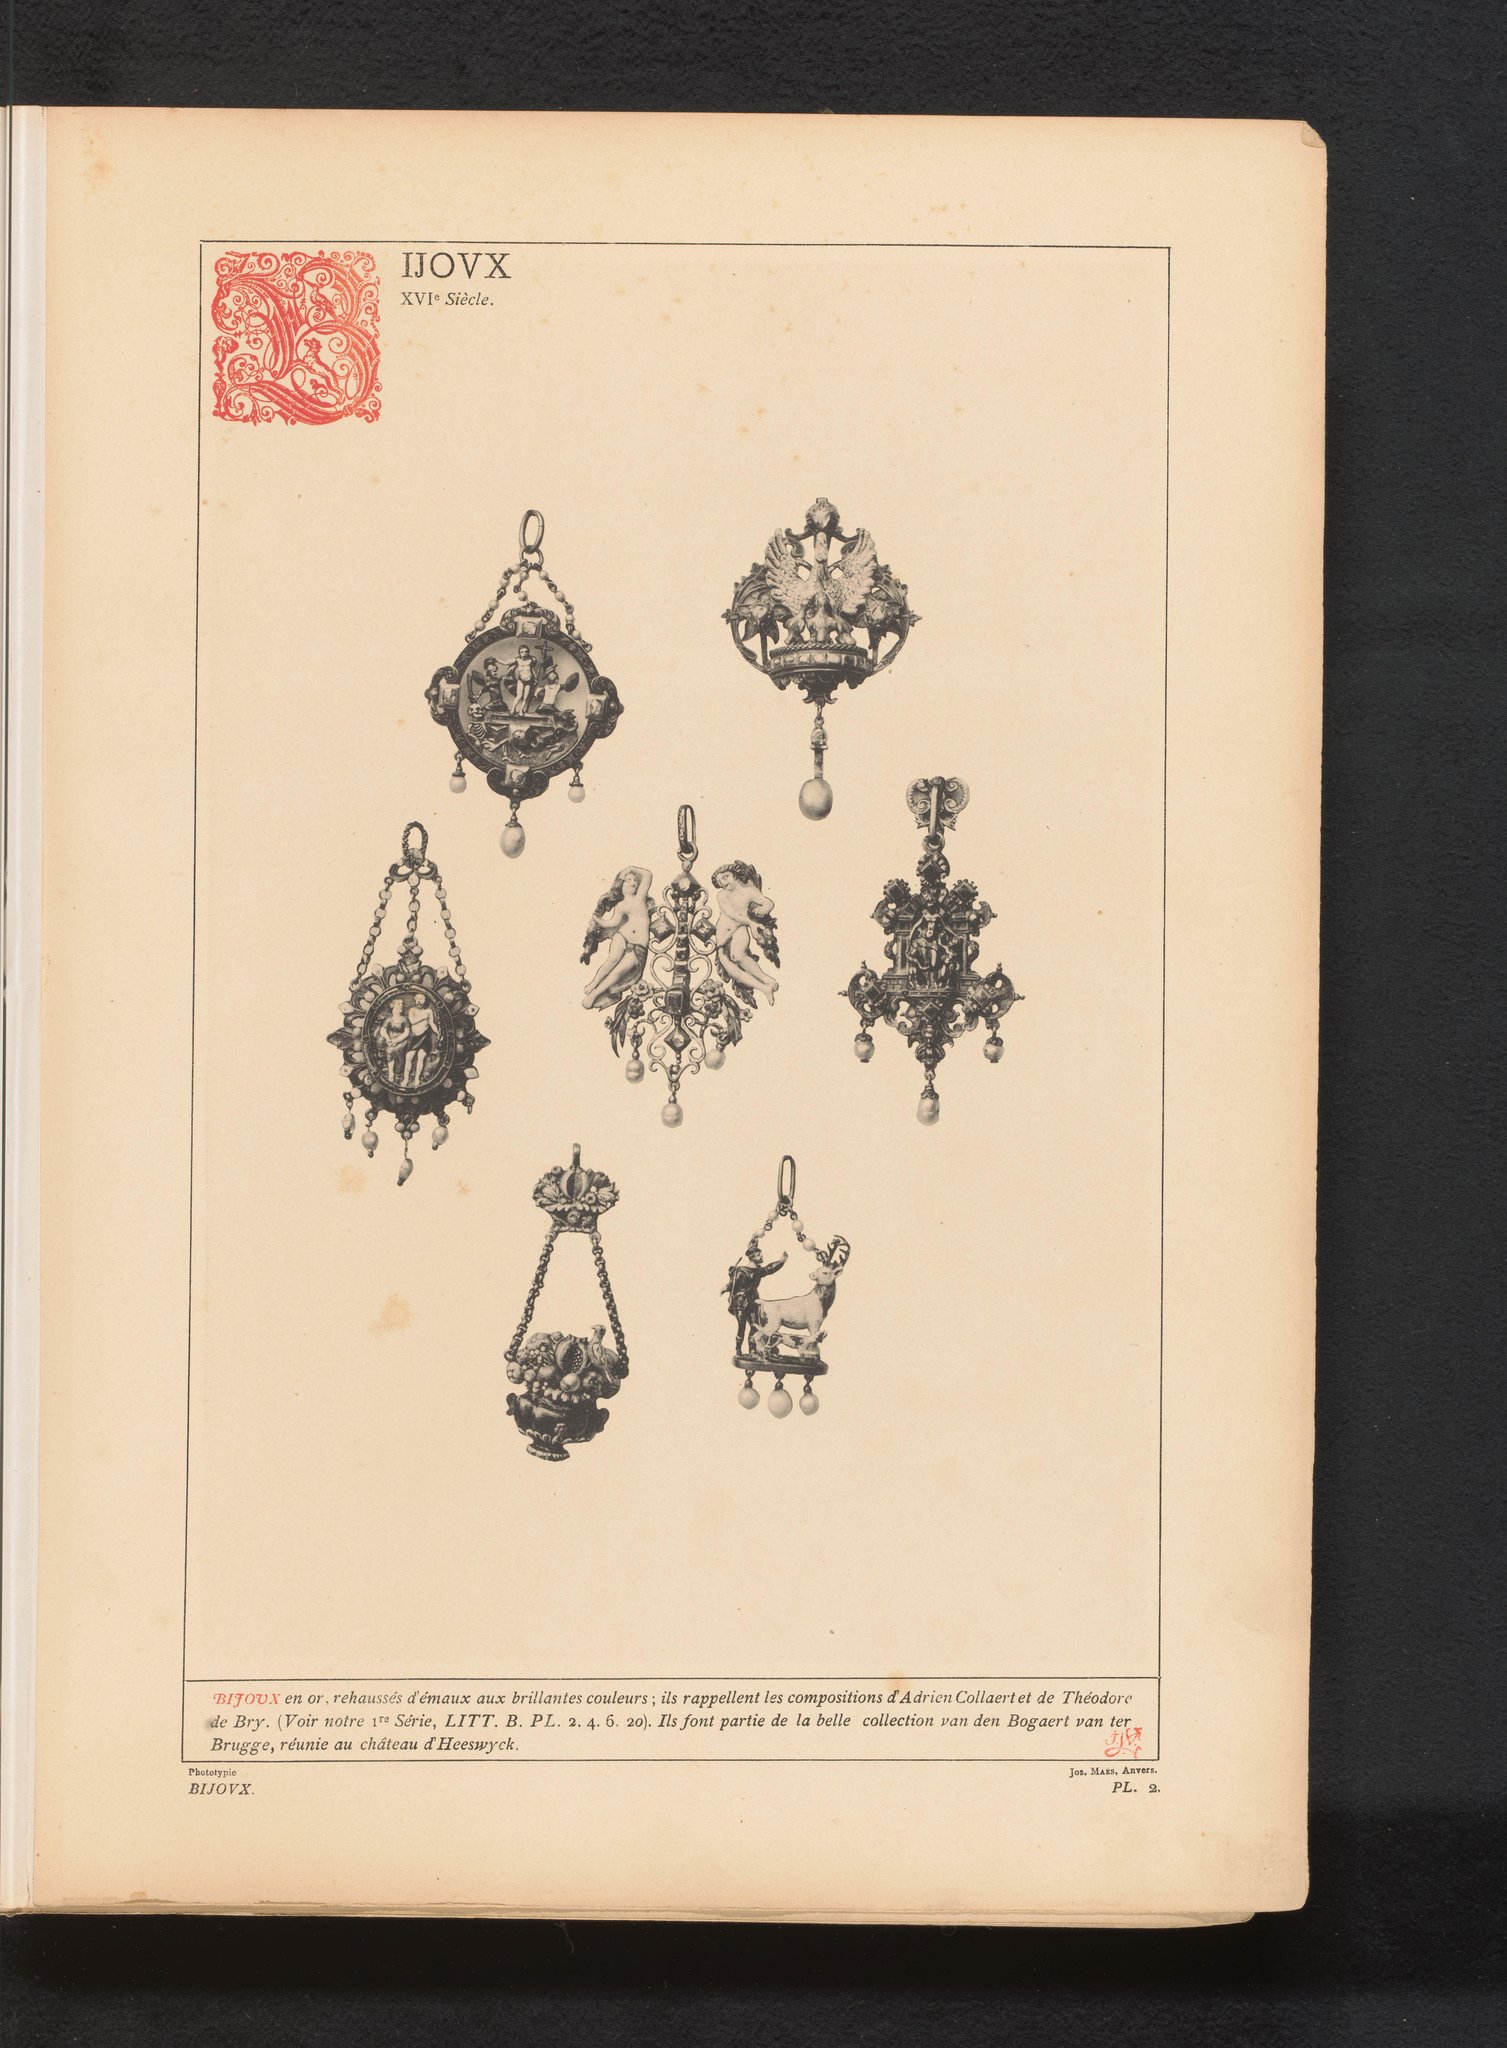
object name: photomechanical print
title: Bijoux, XVIe Siècle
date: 1881-1889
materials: paper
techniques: photograph, photolithography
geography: antwerp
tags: ornaments, jewels, capital (~ column, pillar)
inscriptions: inscription: ‘BIJOUX en or (...)’, inscription: ‘BIJOUX. PL.2.’, monogram: ‘JJvY’